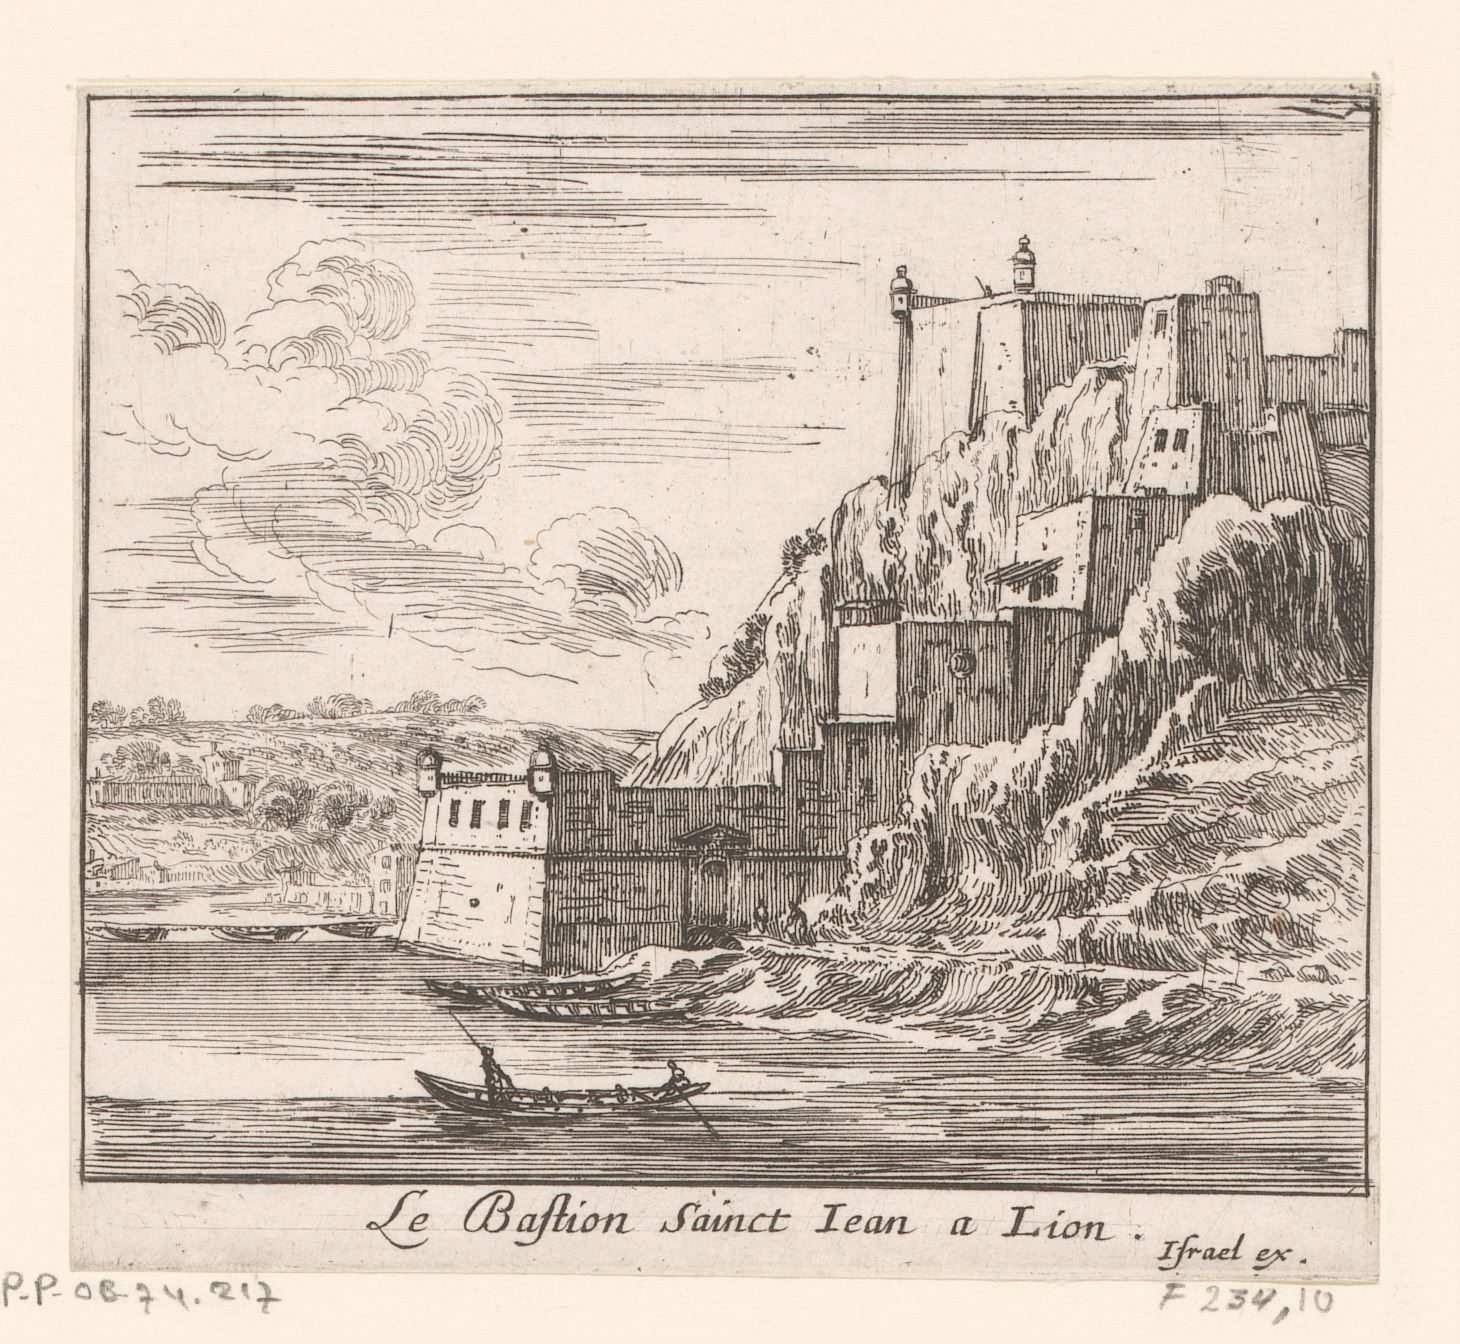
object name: print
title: Diverse gezichten op Lyon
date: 1652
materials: paper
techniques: engraving, etching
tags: city-view, and landscape with man-made constructions, bastion, bulwark, lyon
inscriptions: collector's mark: Lugt 240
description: Prent maakt deel uit van een ongenummerde serie van dertien prenten.